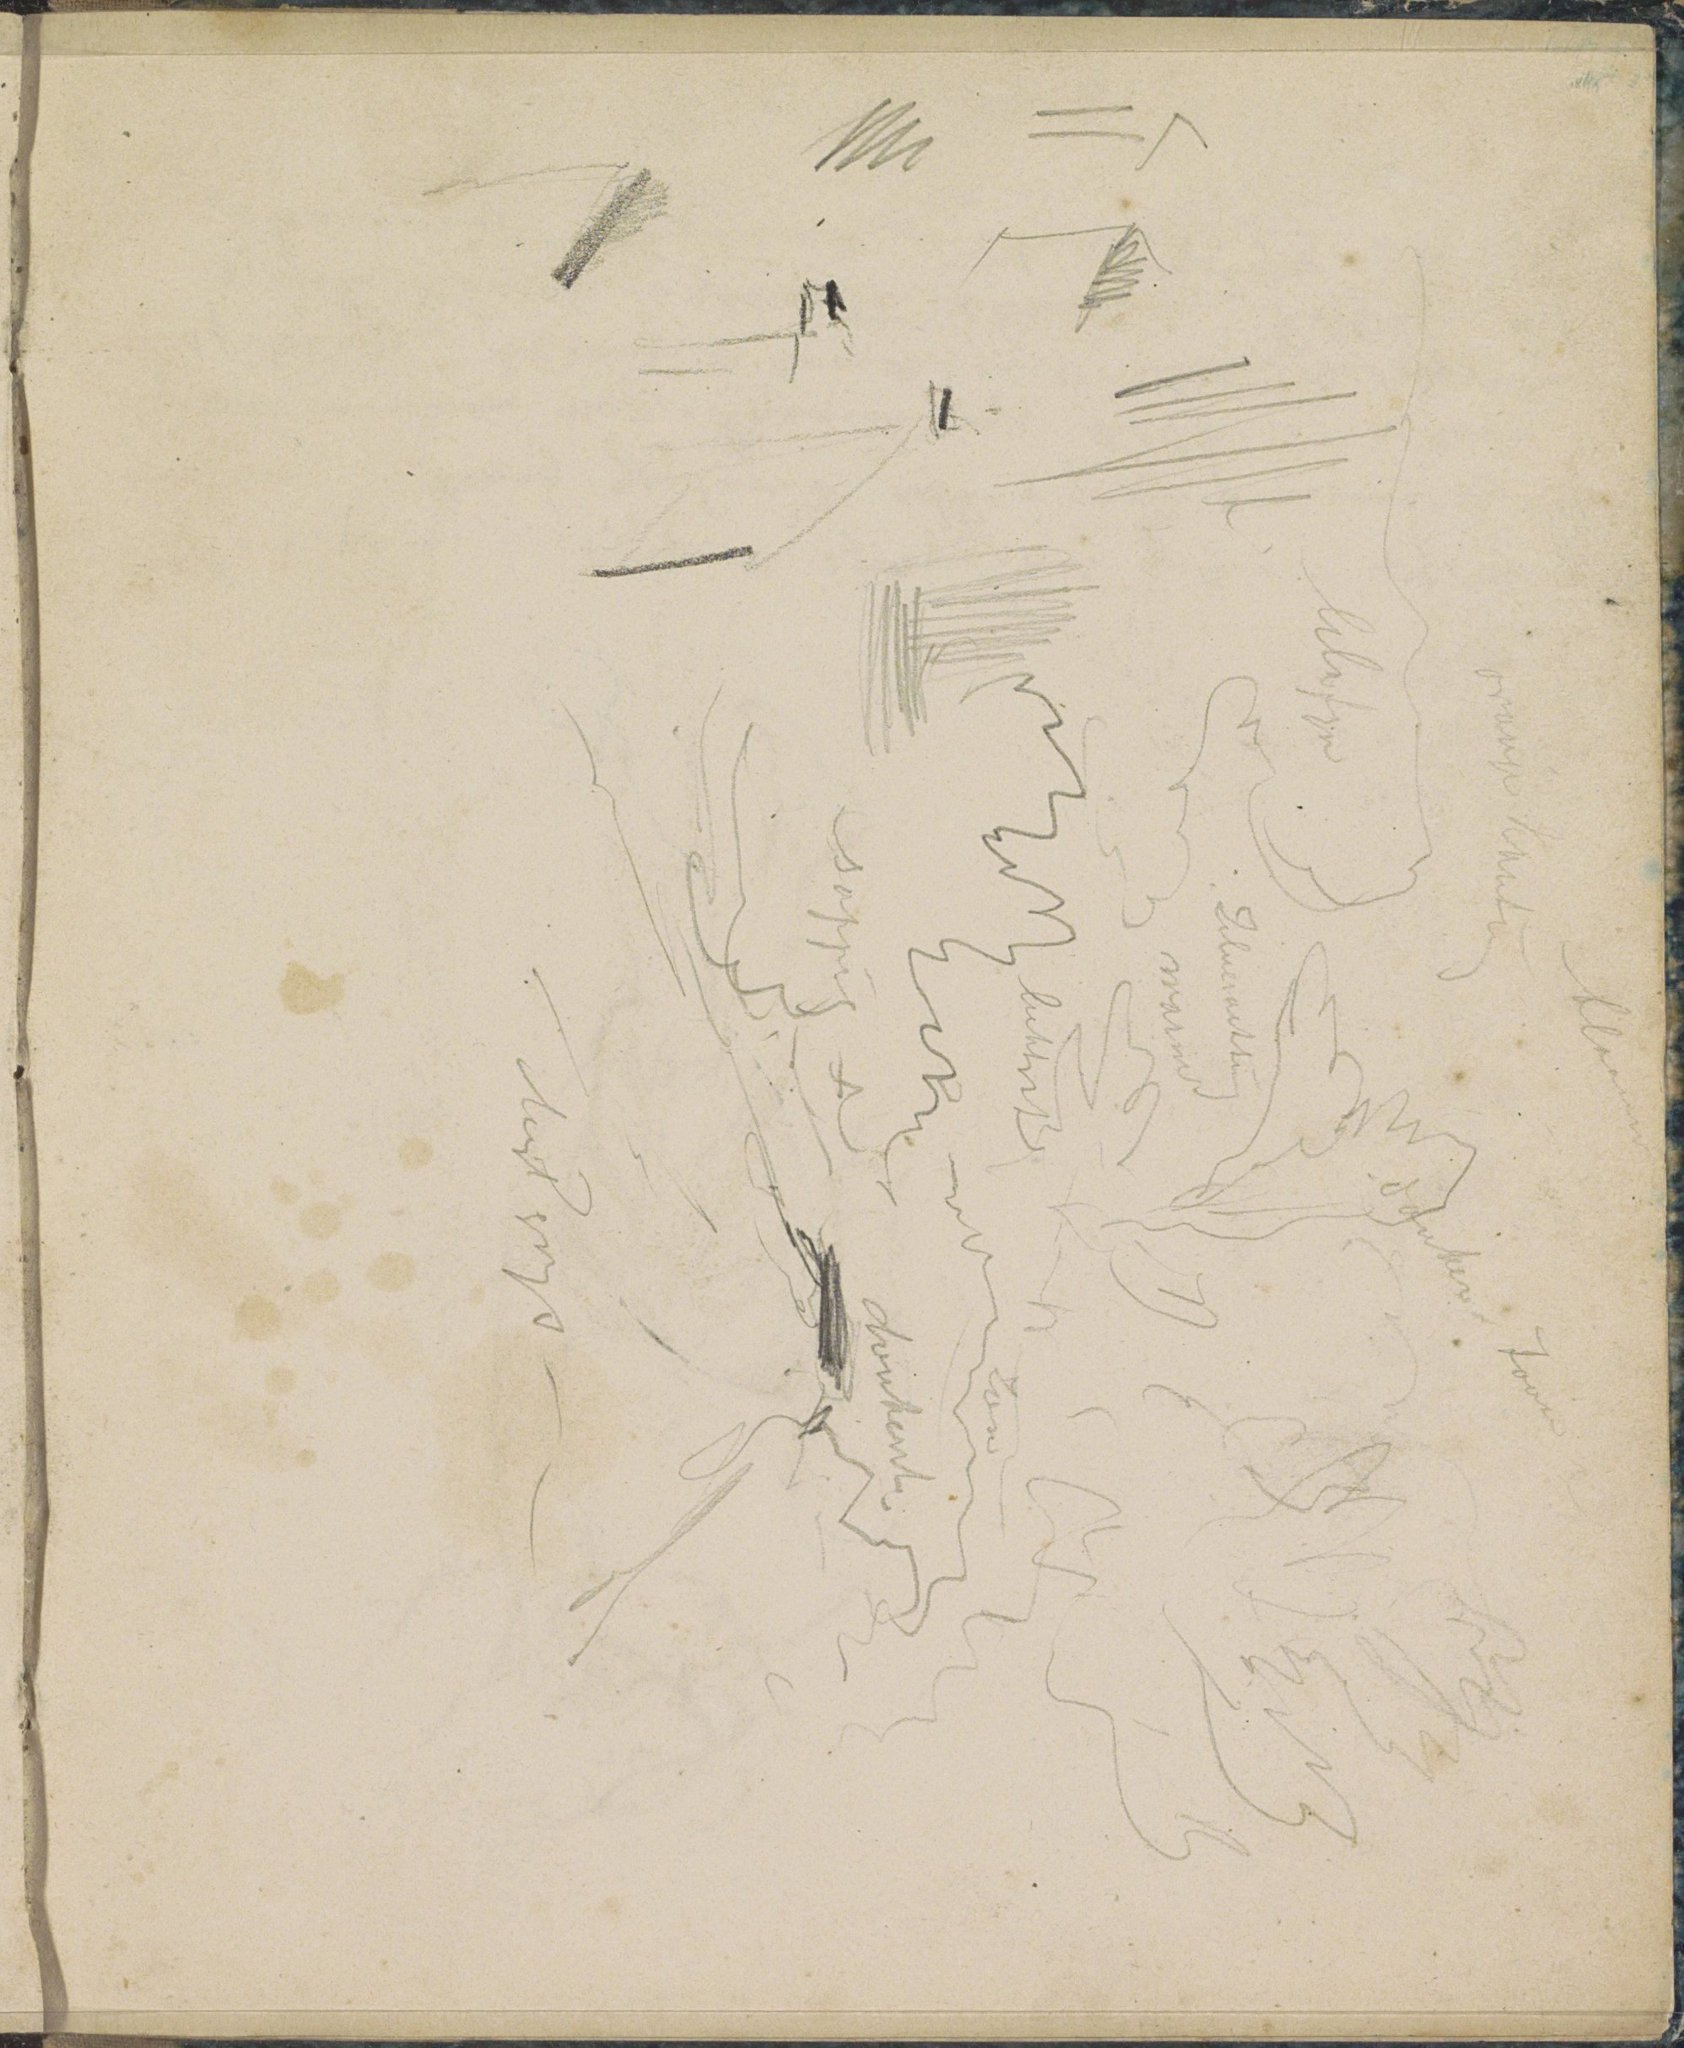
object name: sketchbook leaf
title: Landschap met bomen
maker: johannes tavenraat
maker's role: draughtsman, painter, print maker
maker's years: 1809-1881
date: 1841-1853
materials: paper, pencil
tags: trees, landscapes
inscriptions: kleurnotitie, handgeschreven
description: Blad 86 recto uit een schetsboek met 87 bladen.